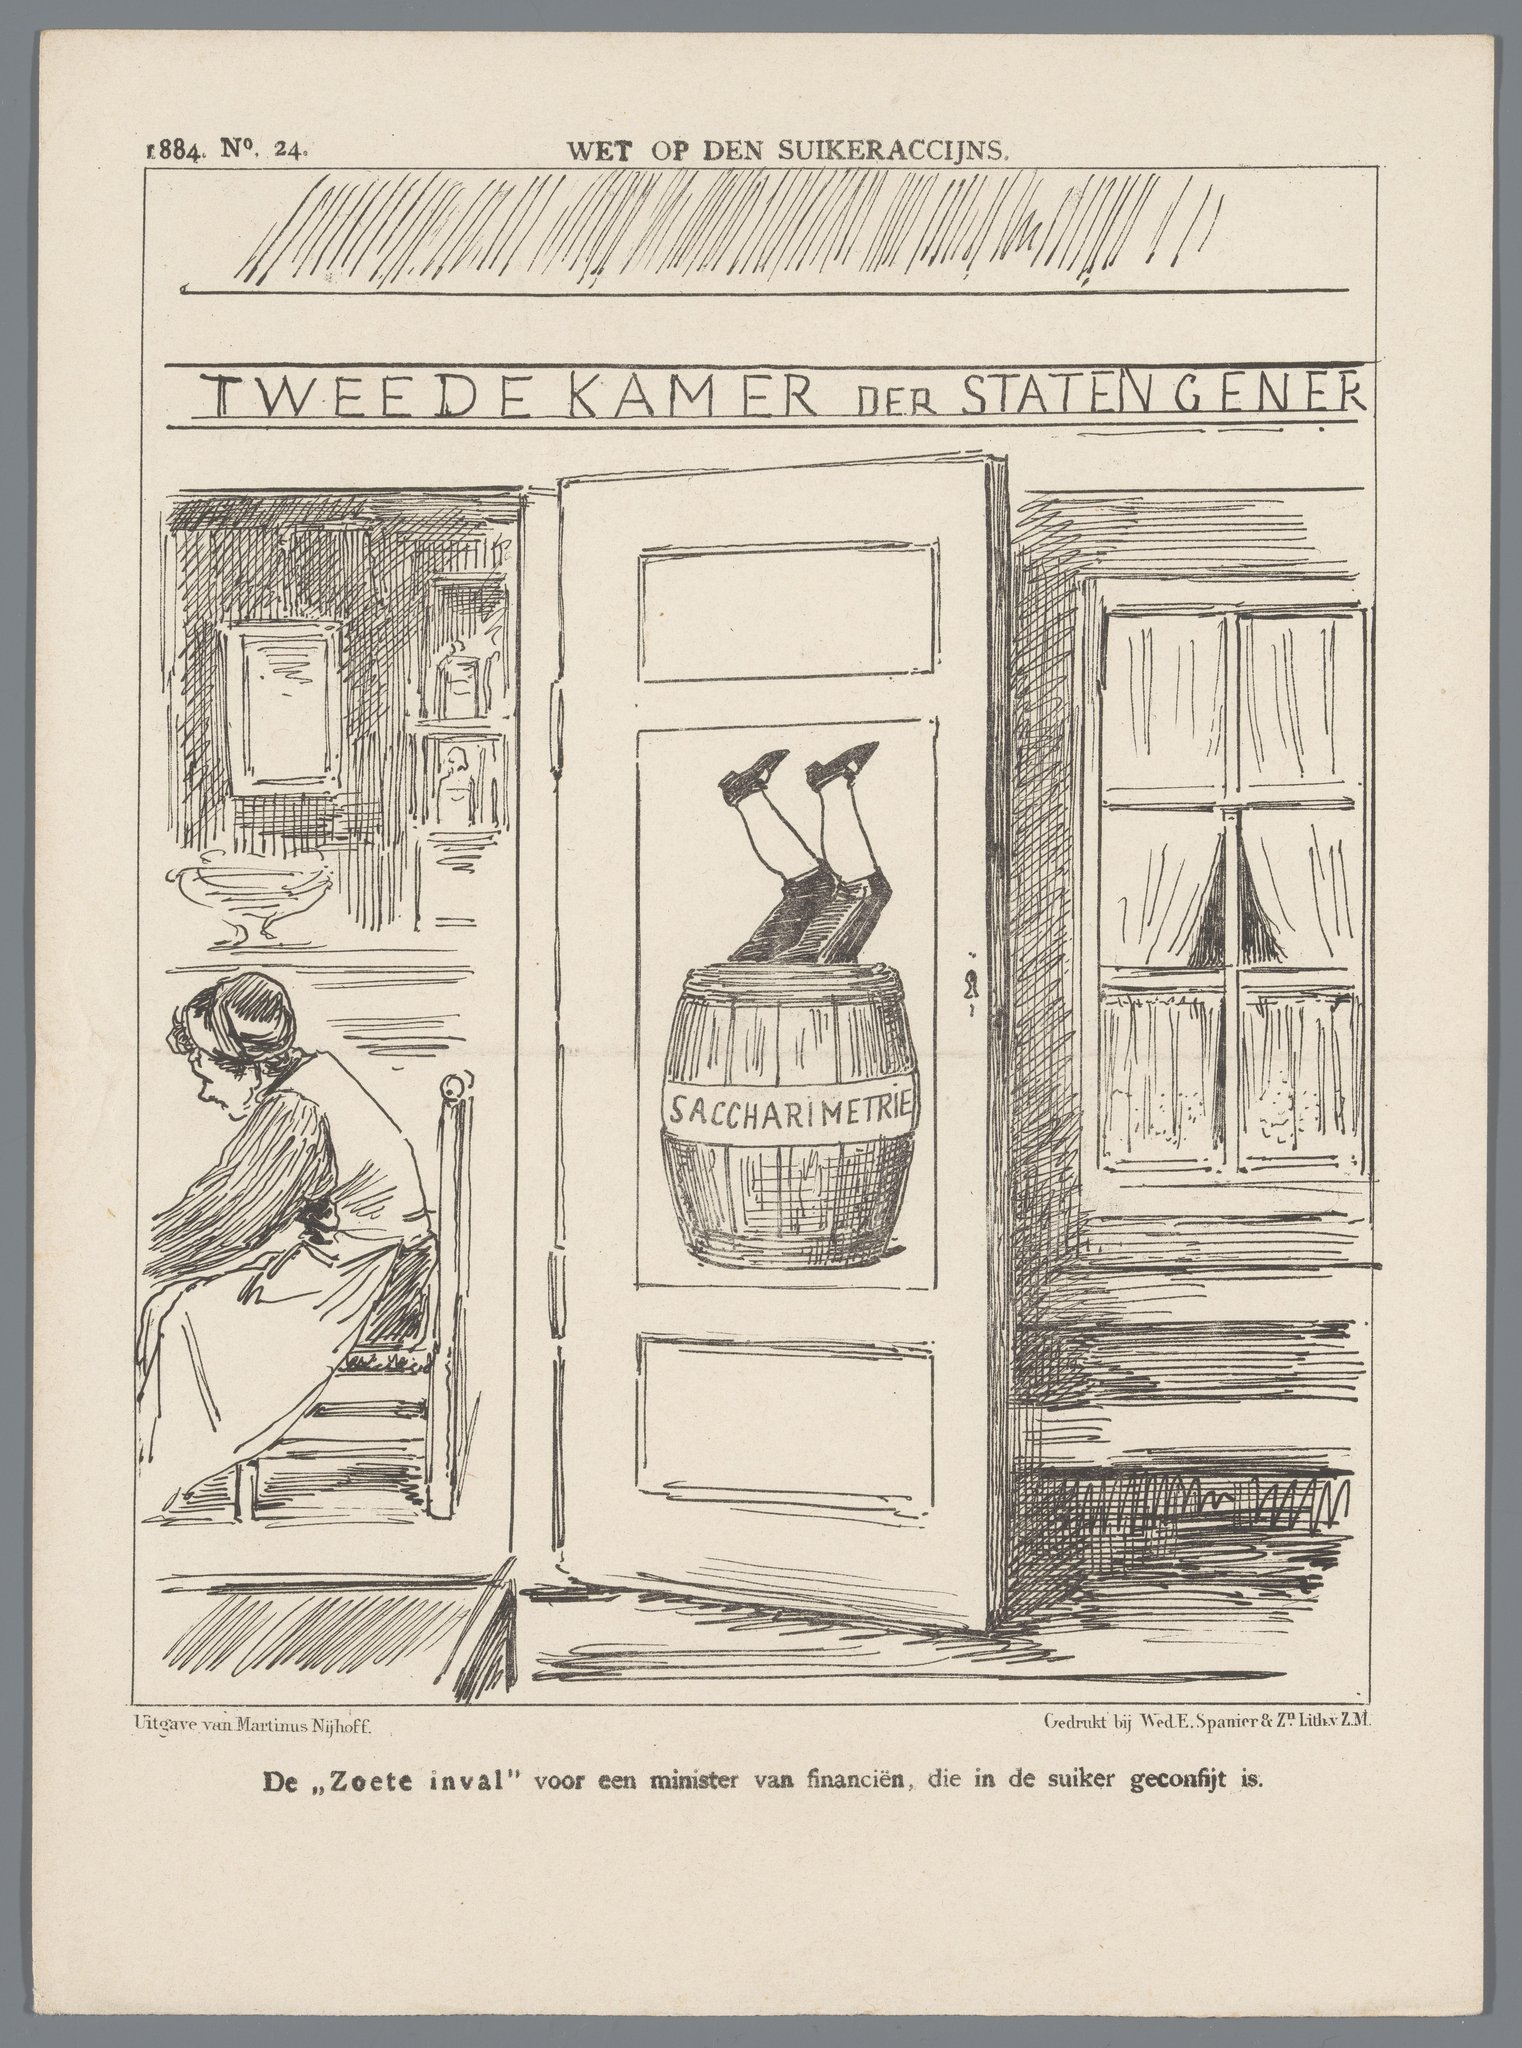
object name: cartoon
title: Spotprent over de suikeraccijns,1884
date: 1884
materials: paper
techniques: lithograph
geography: netherlands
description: Spotprent over de suikeraccijns. Plaat verschenen bij het weekblad De Nederlandsche Spectator, nr. 24, 1884.